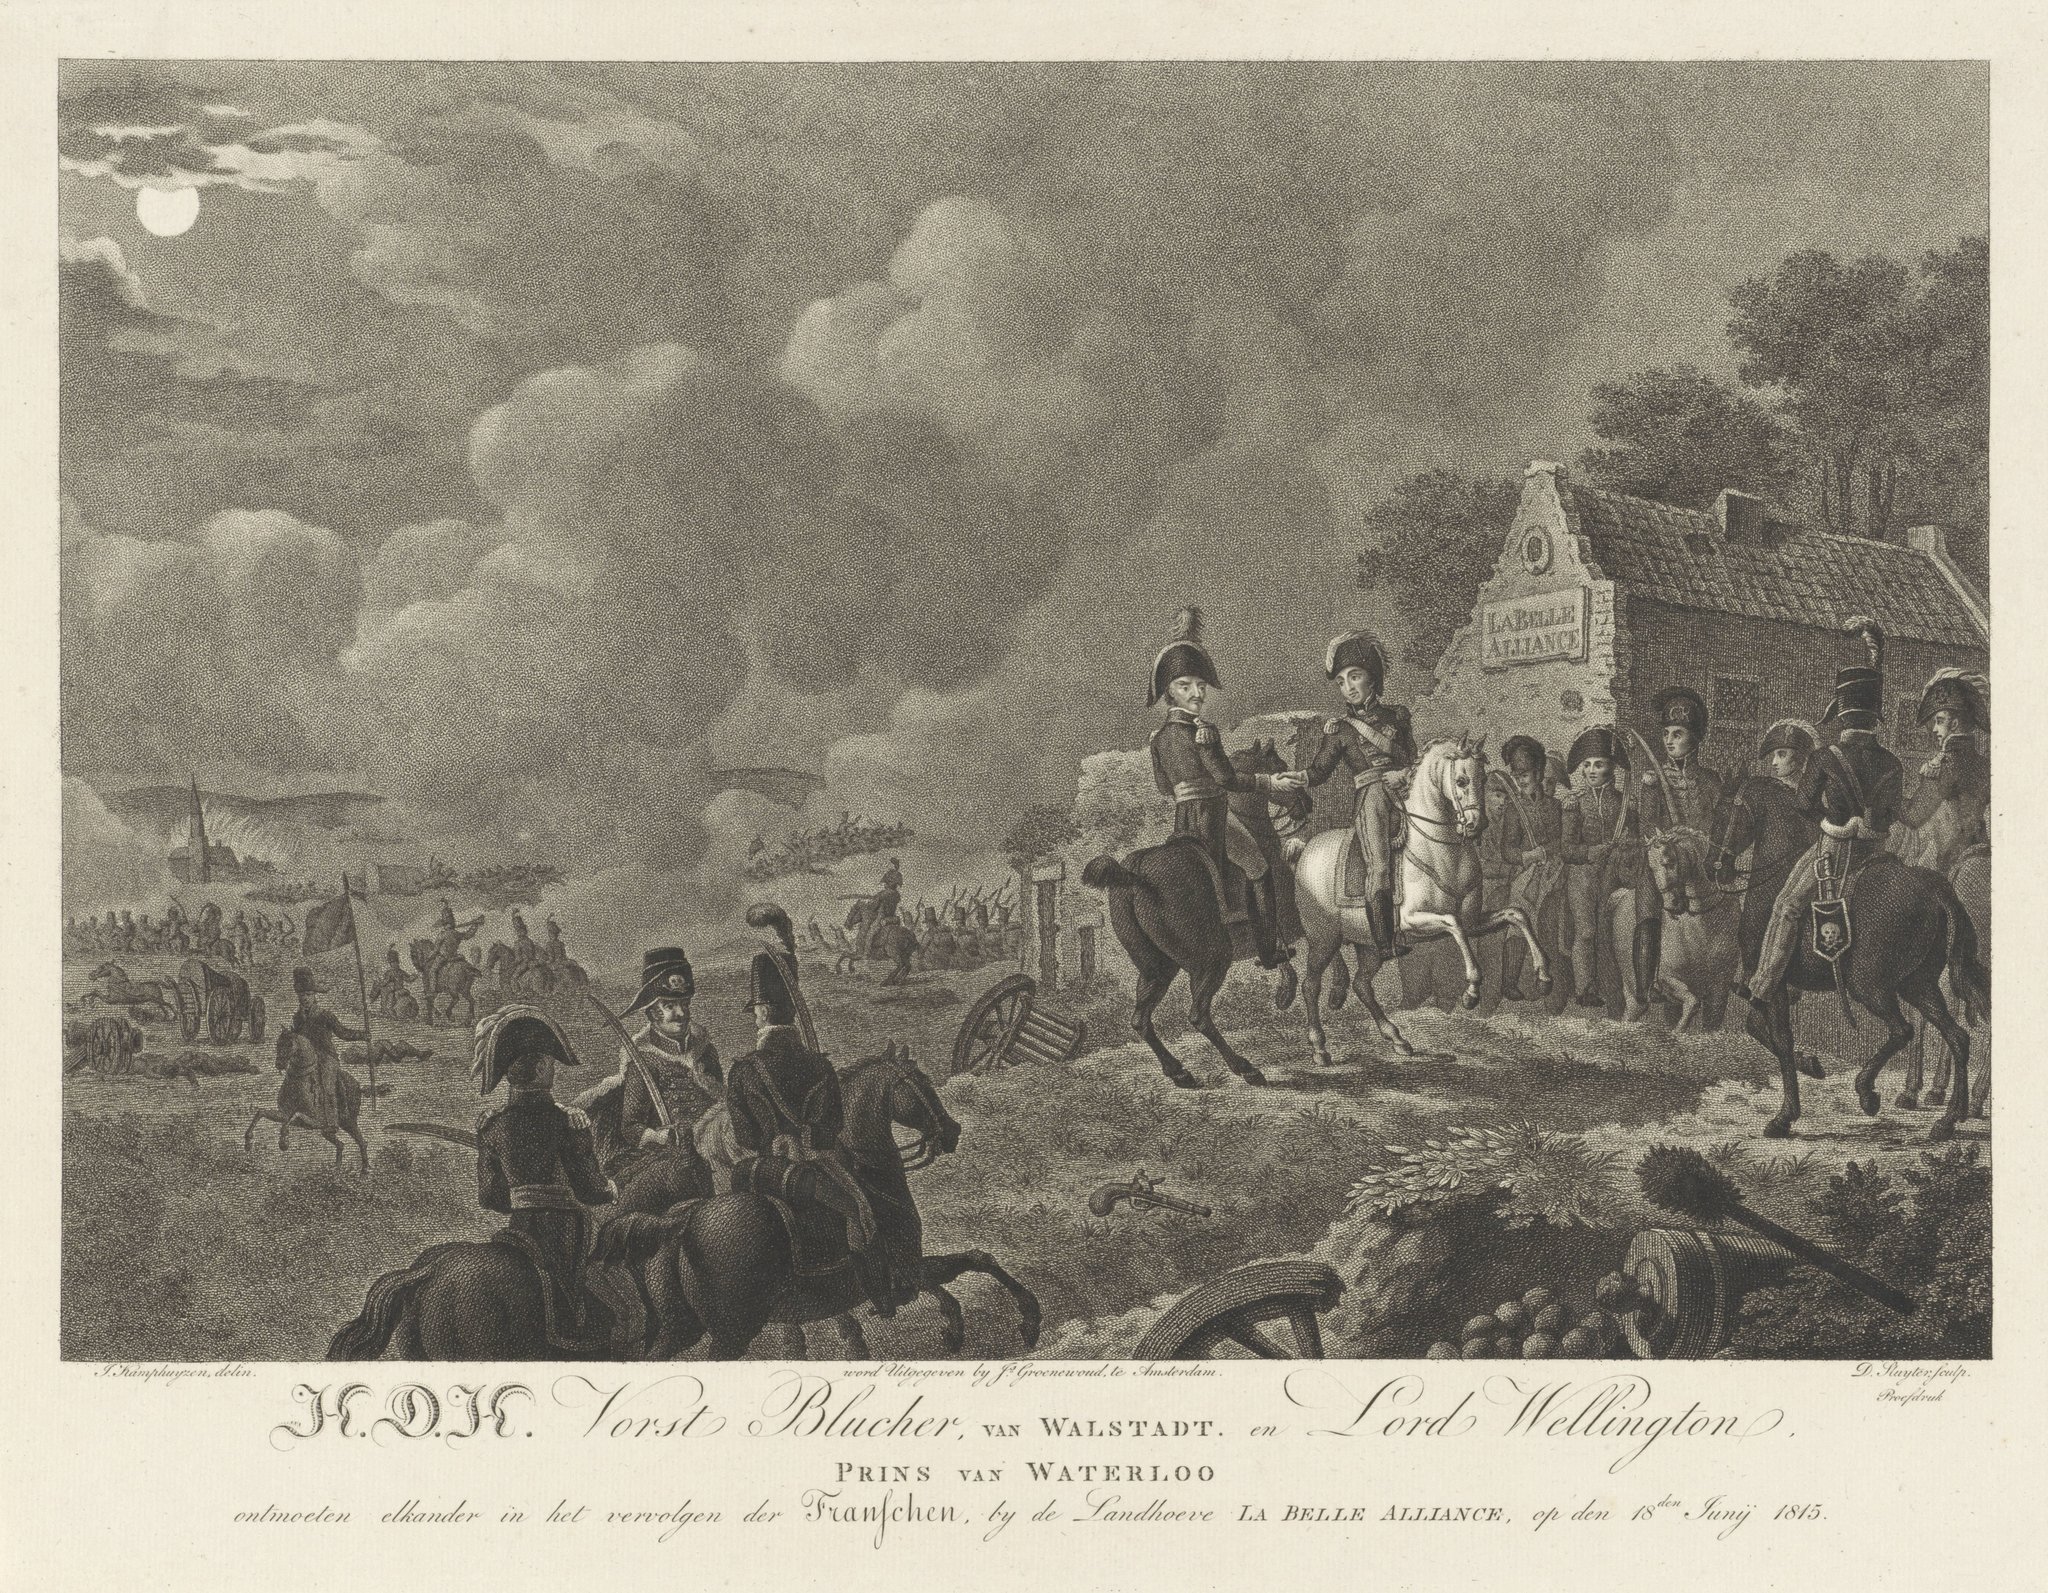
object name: print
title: Ontmoeting van prins Blücher von Wahlstatt en Lord Wellington bij La Belle Alliance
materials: paper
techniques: engraving, etching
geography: amsterdam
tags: walmer castle, arthur wellesley of wellington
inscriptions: collector's mark: Lugt 2228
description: De Pruisische Prins Blücher von Wahlstatt en de Engelse Lord Wellington schudden elkaar de hand bij La Belle Alliance, het voormalig hoofdkwartier van de verslagen Napoleon op 18 juni 1815. Op de achtergrond de rokende puinhopen van het slagveld. Met een verklarend onderschrift.